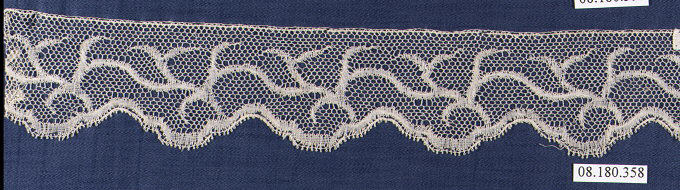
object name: piece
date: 1801-1900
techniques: lace